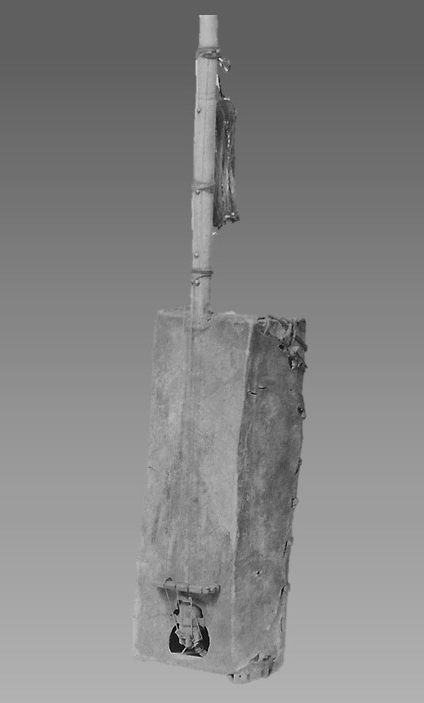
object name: sintir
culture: sudanese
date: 1801-1900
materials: leather, skin, wood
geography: sudan